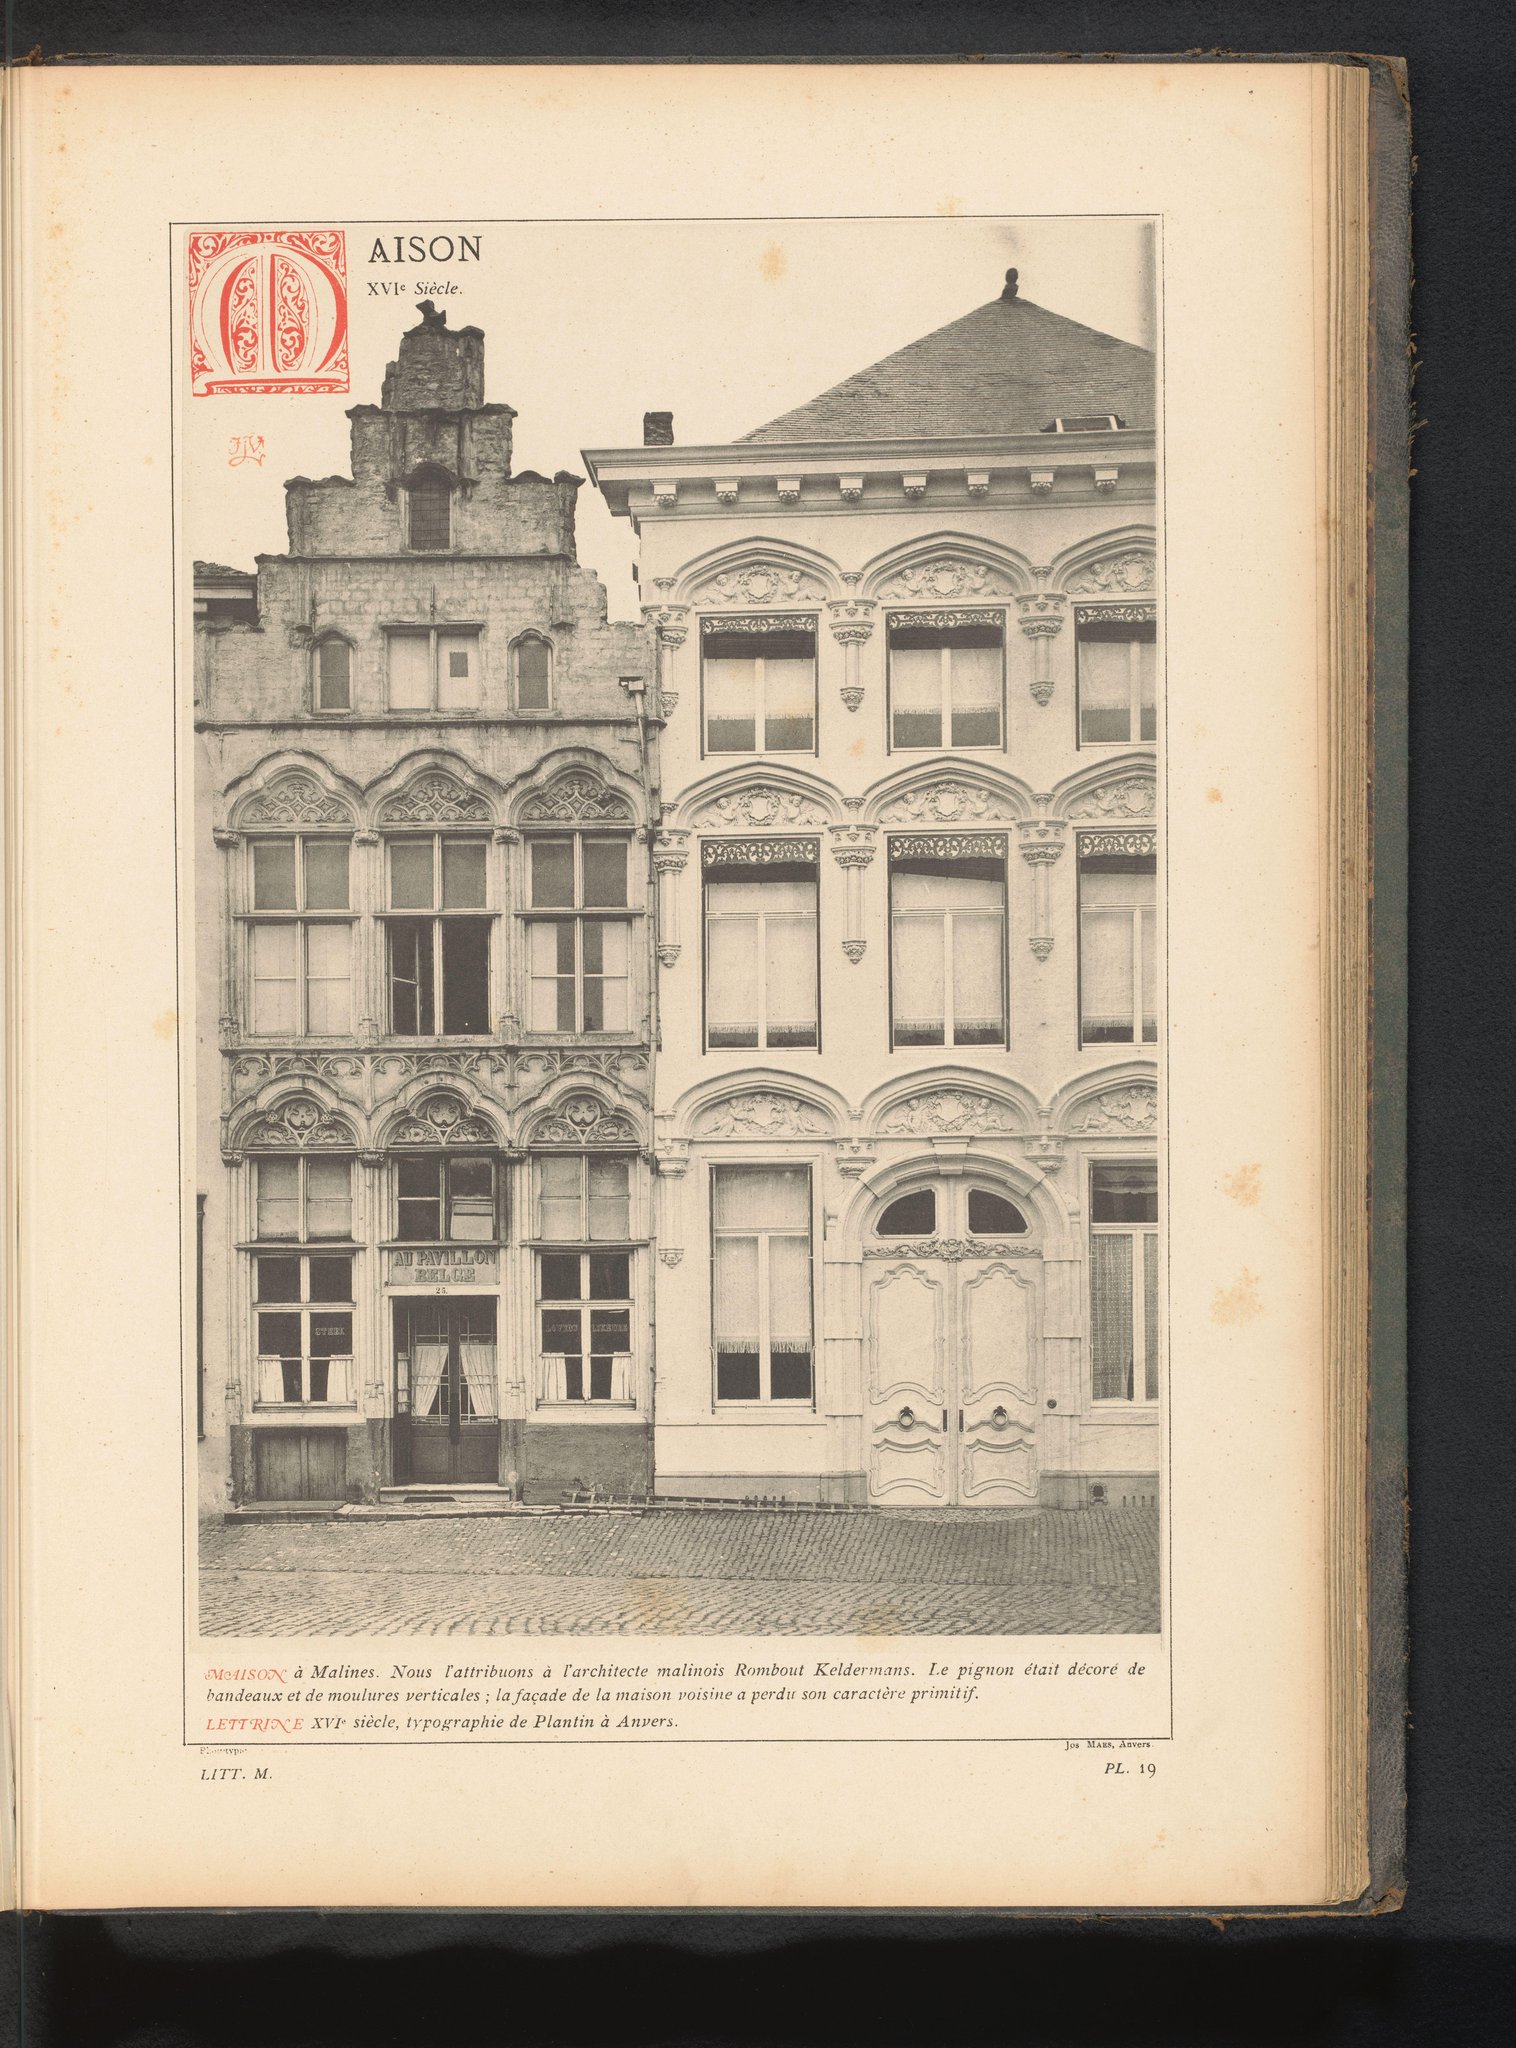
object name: photomechanical print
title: Gezicht op twee huizen in Mechelen, België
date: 1875-1880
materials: paper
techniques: photograph, photolithography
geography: antwerp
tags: civic architecture; edifices; dwellings, mechelen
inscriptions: inscription: ‘MAISON à Malines (...)’, monogram: ‘JJvY’, inscription: ‘LITT. M. - PL. 19’